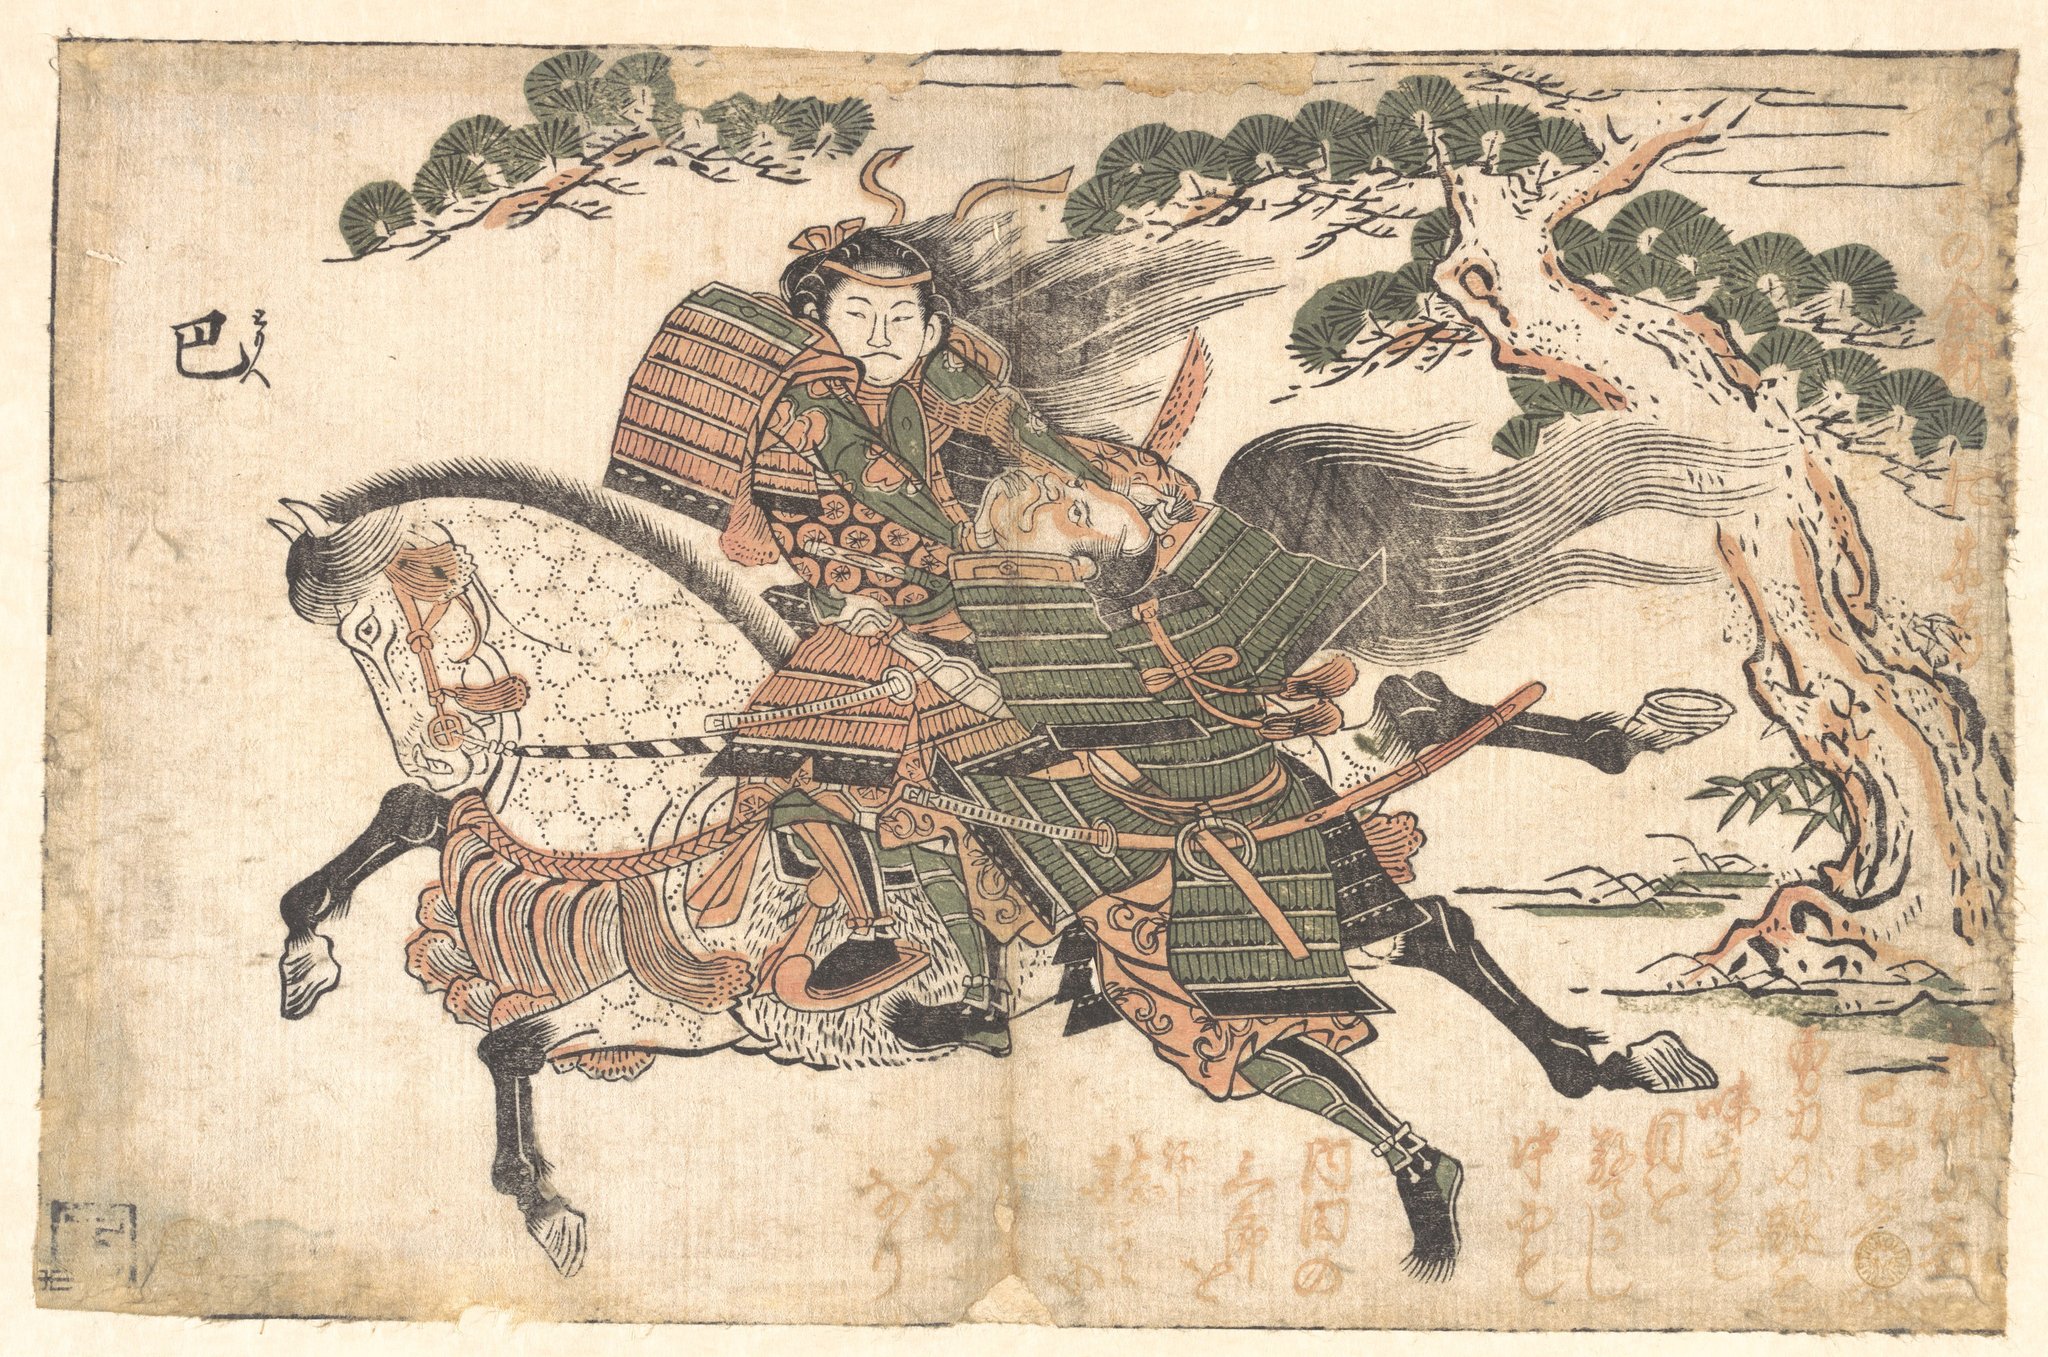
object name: print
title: Tomoe Gozen Killing Uchida Saburo Ieyoshi at the Battle of Awazu no Hara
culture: japanese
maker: ishikawa toyonobu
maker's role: artist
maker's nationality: japanese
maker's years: 1711-1785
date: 1750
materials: ink, paper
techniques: woodblock print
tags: battles,swords,men,horses,trees